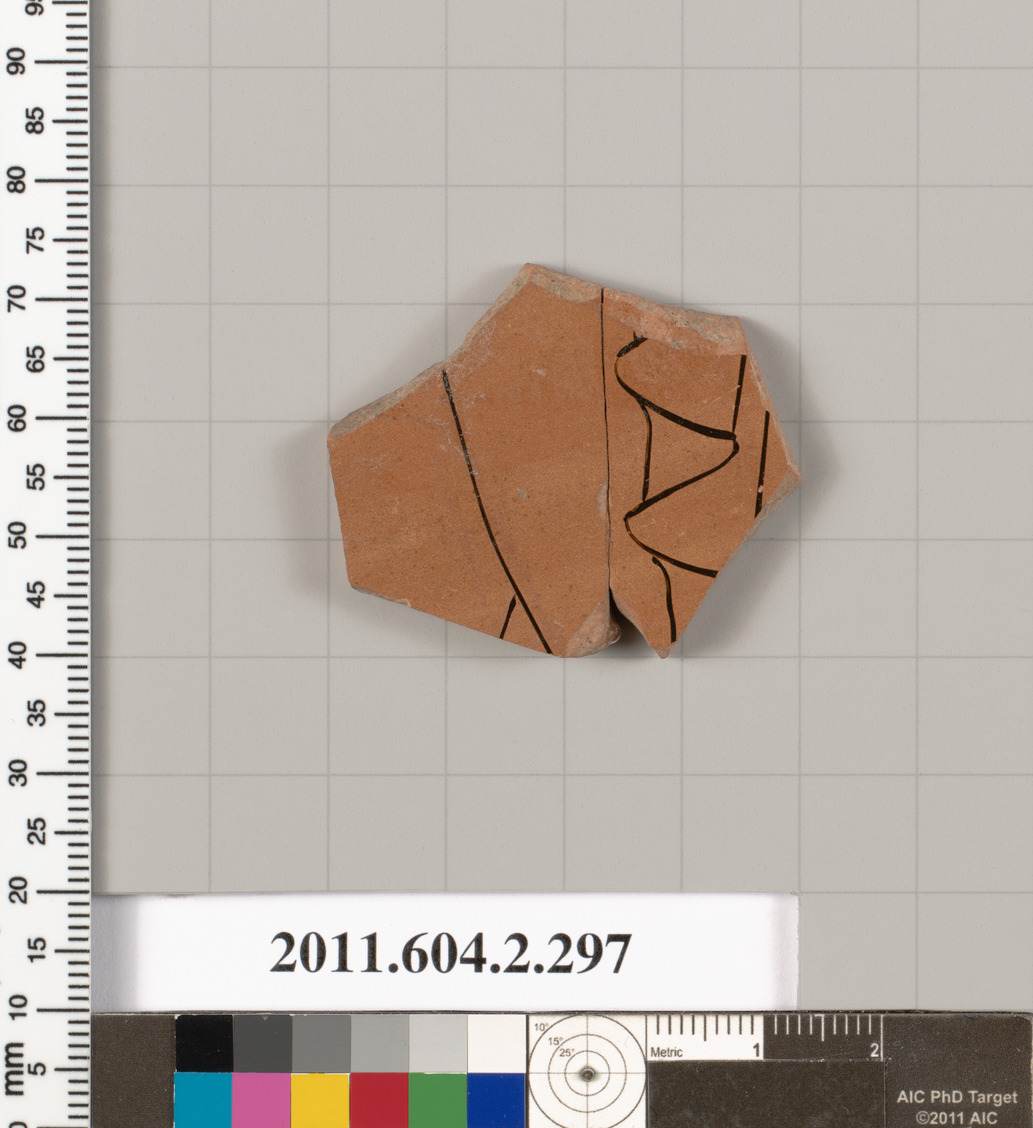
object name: column krater fragment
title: Terracotta fragment of a column-krater (bowl for mixing wine and water)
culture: greek, attic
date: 460-440 BCE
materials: terracotta